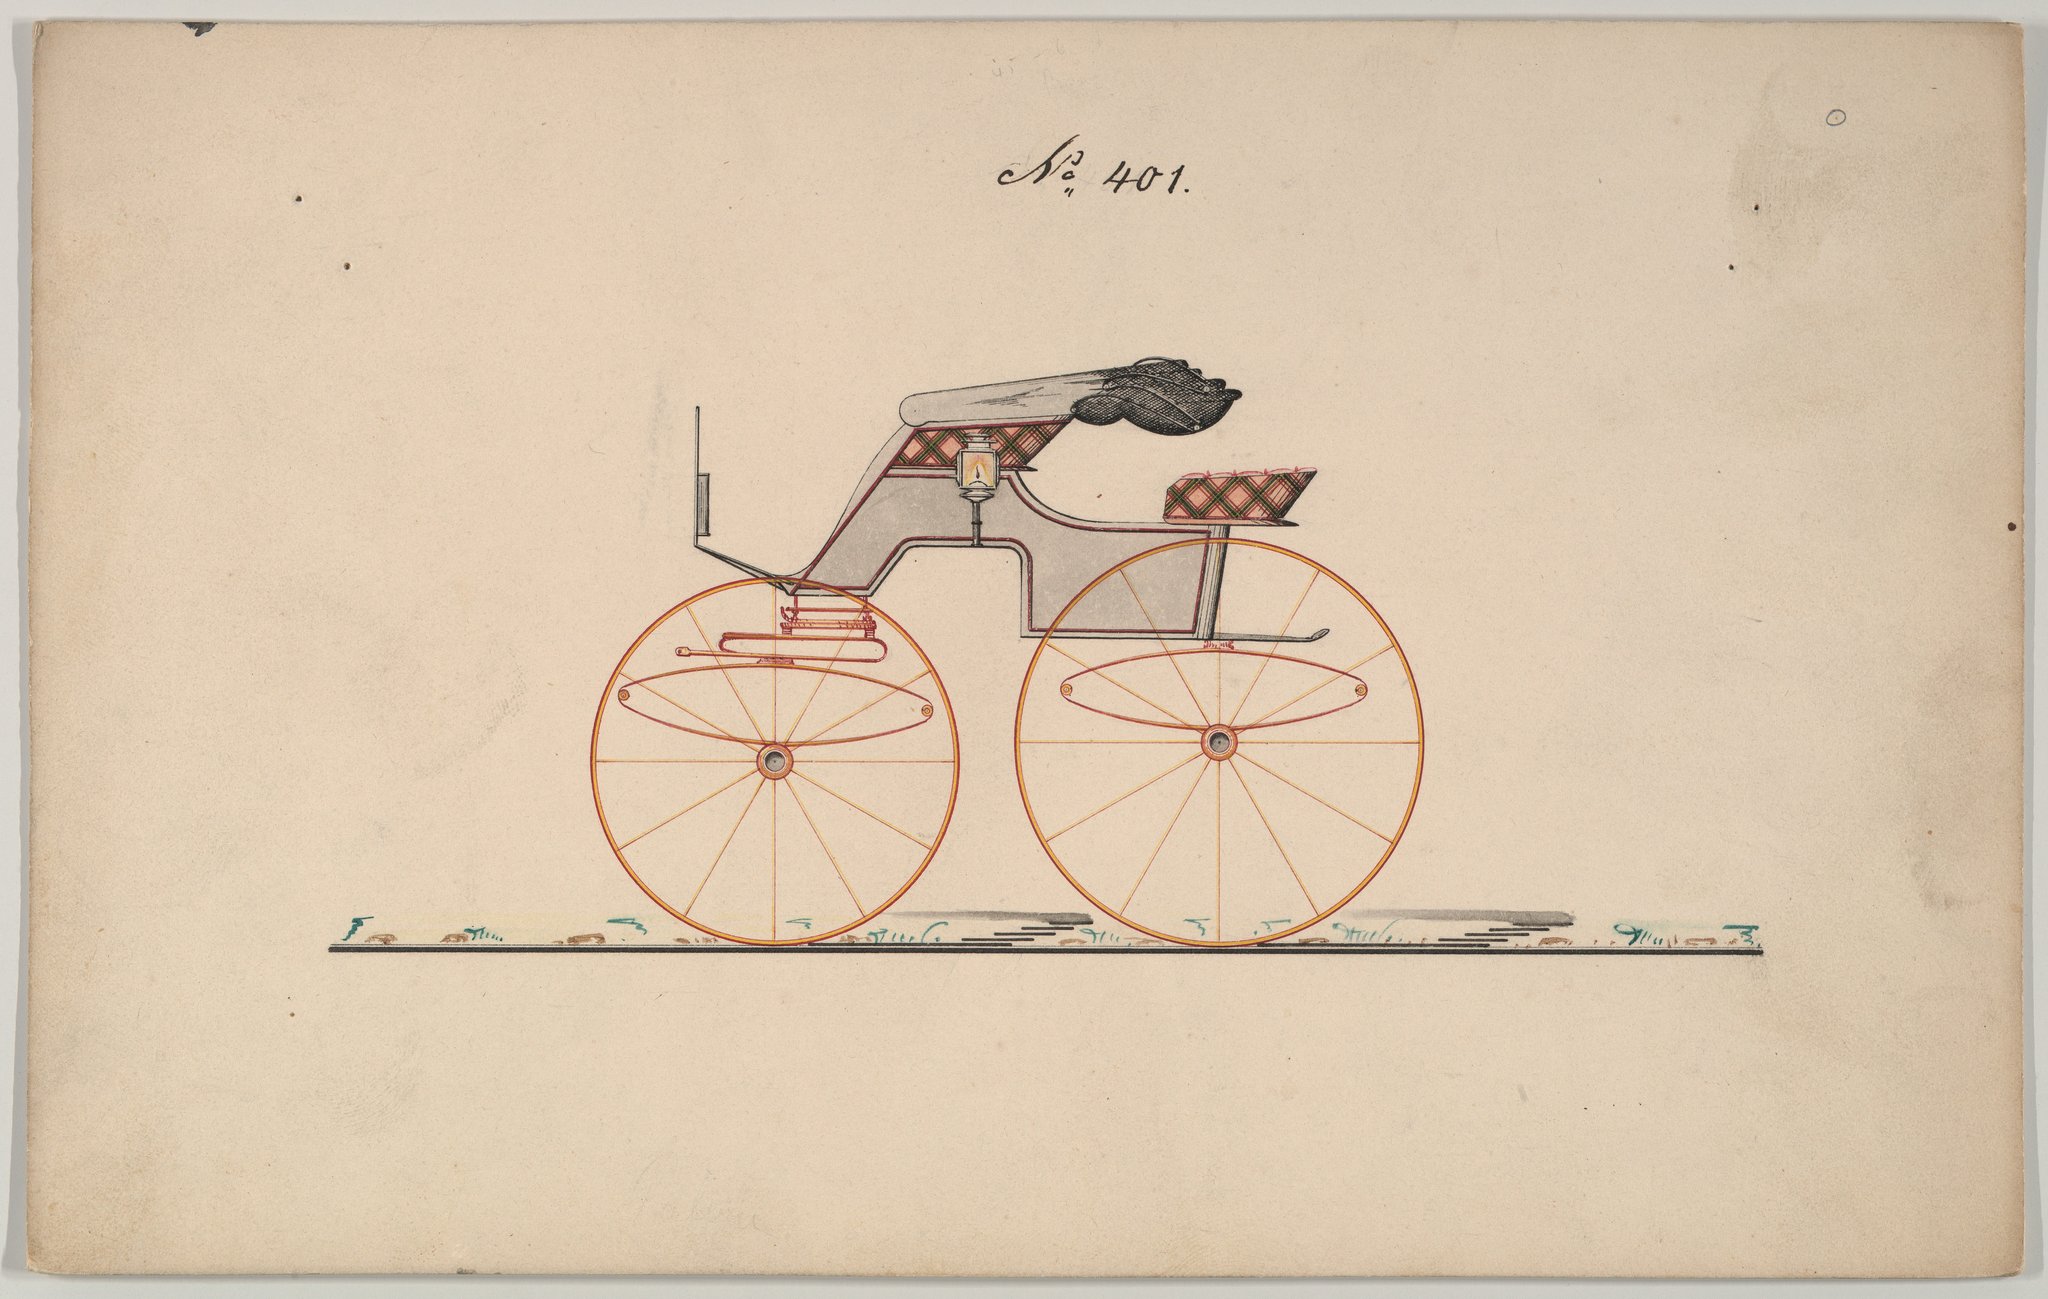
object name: drawing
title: Design for Road Wagon with Folding Top ("4 seat Wagon"), no. 401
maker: brewster & co.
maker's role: manufacturer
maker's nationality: american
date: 1850-1874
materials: gouache, ink, watercolor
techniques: pen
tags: carriages